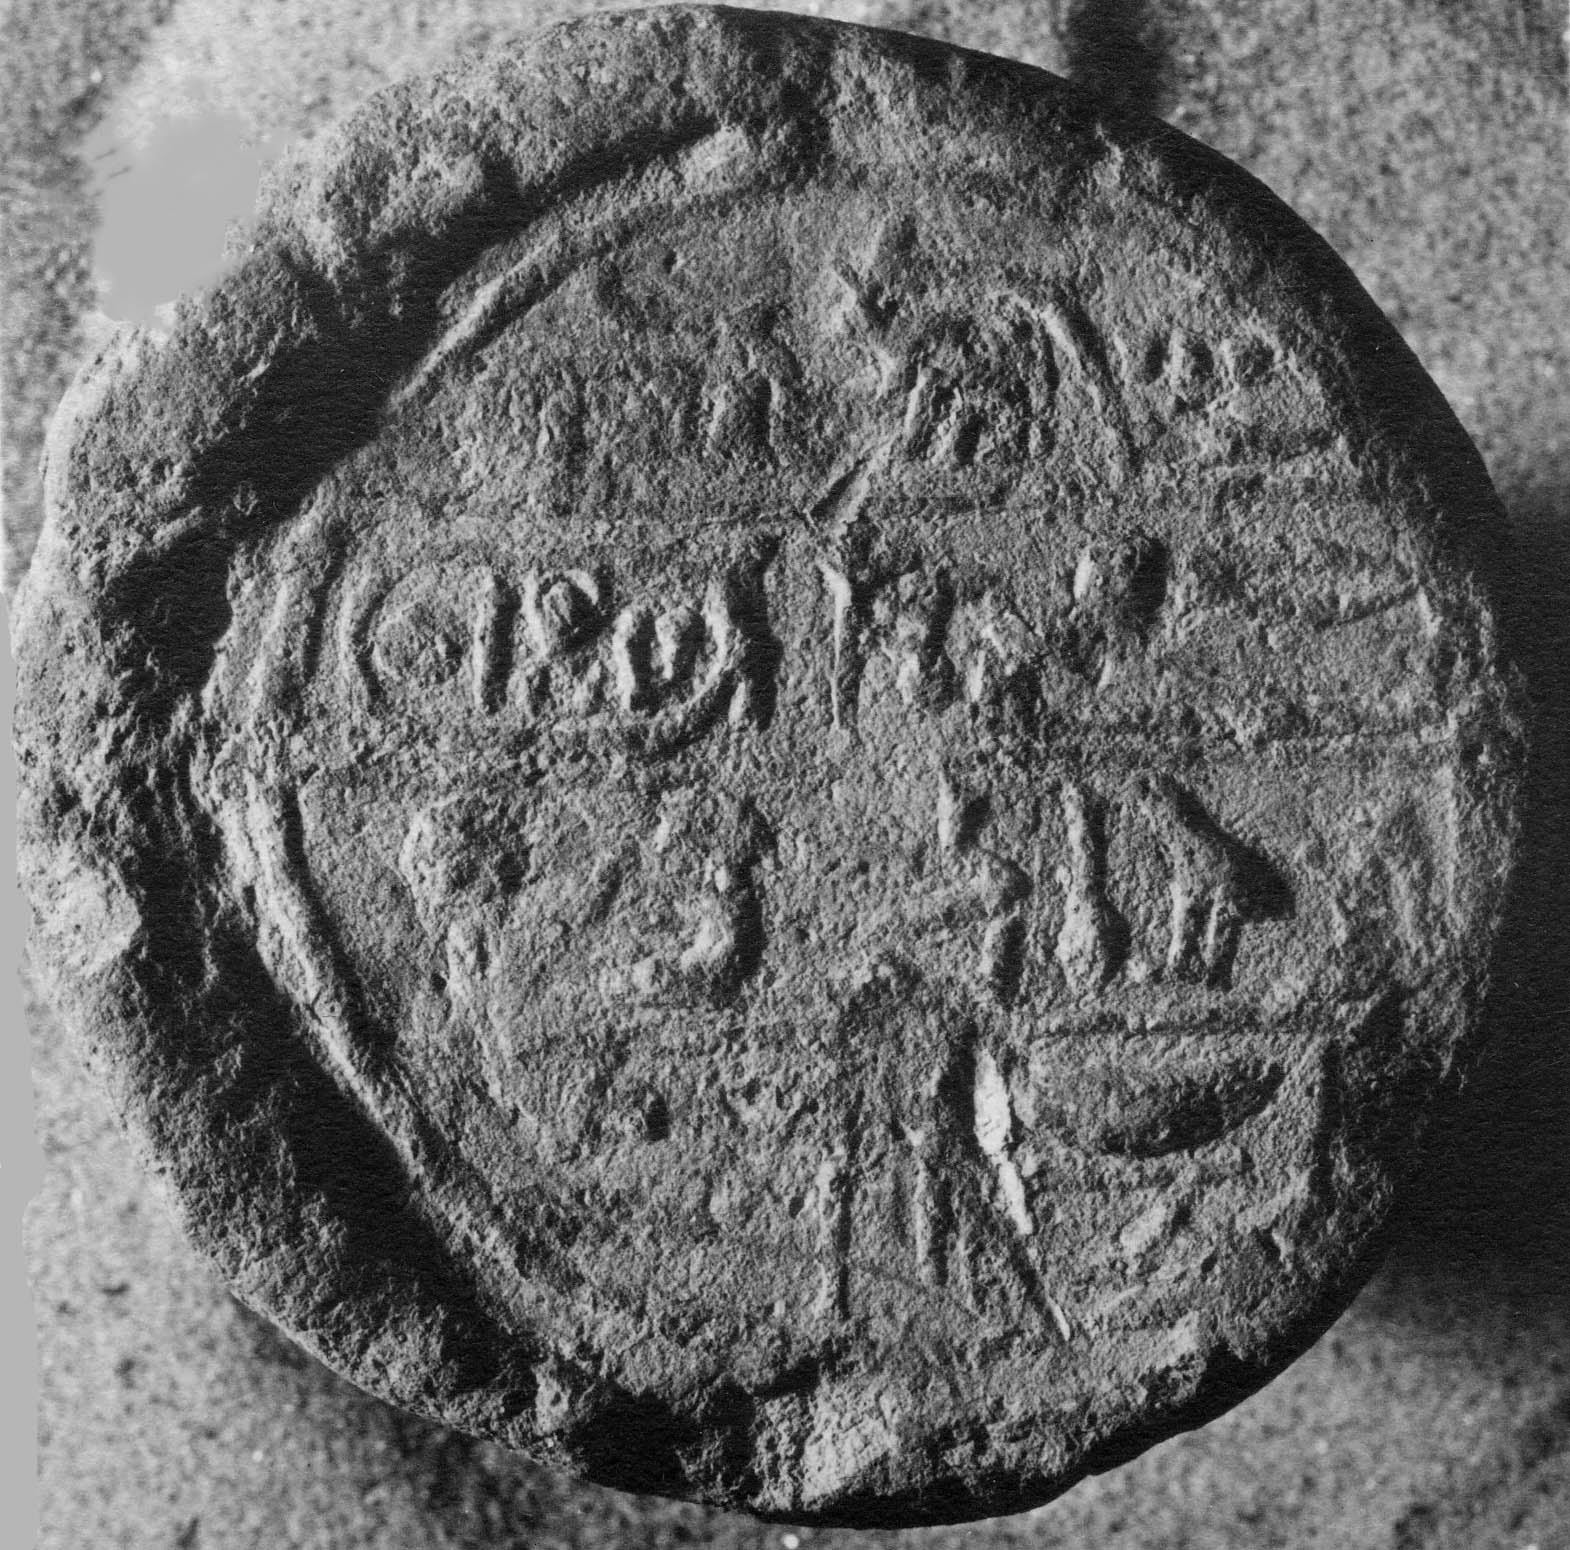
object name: cone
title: Funerary Cone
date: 1550-1295 BCE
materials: pottery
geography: egypt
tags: hieroglyphs